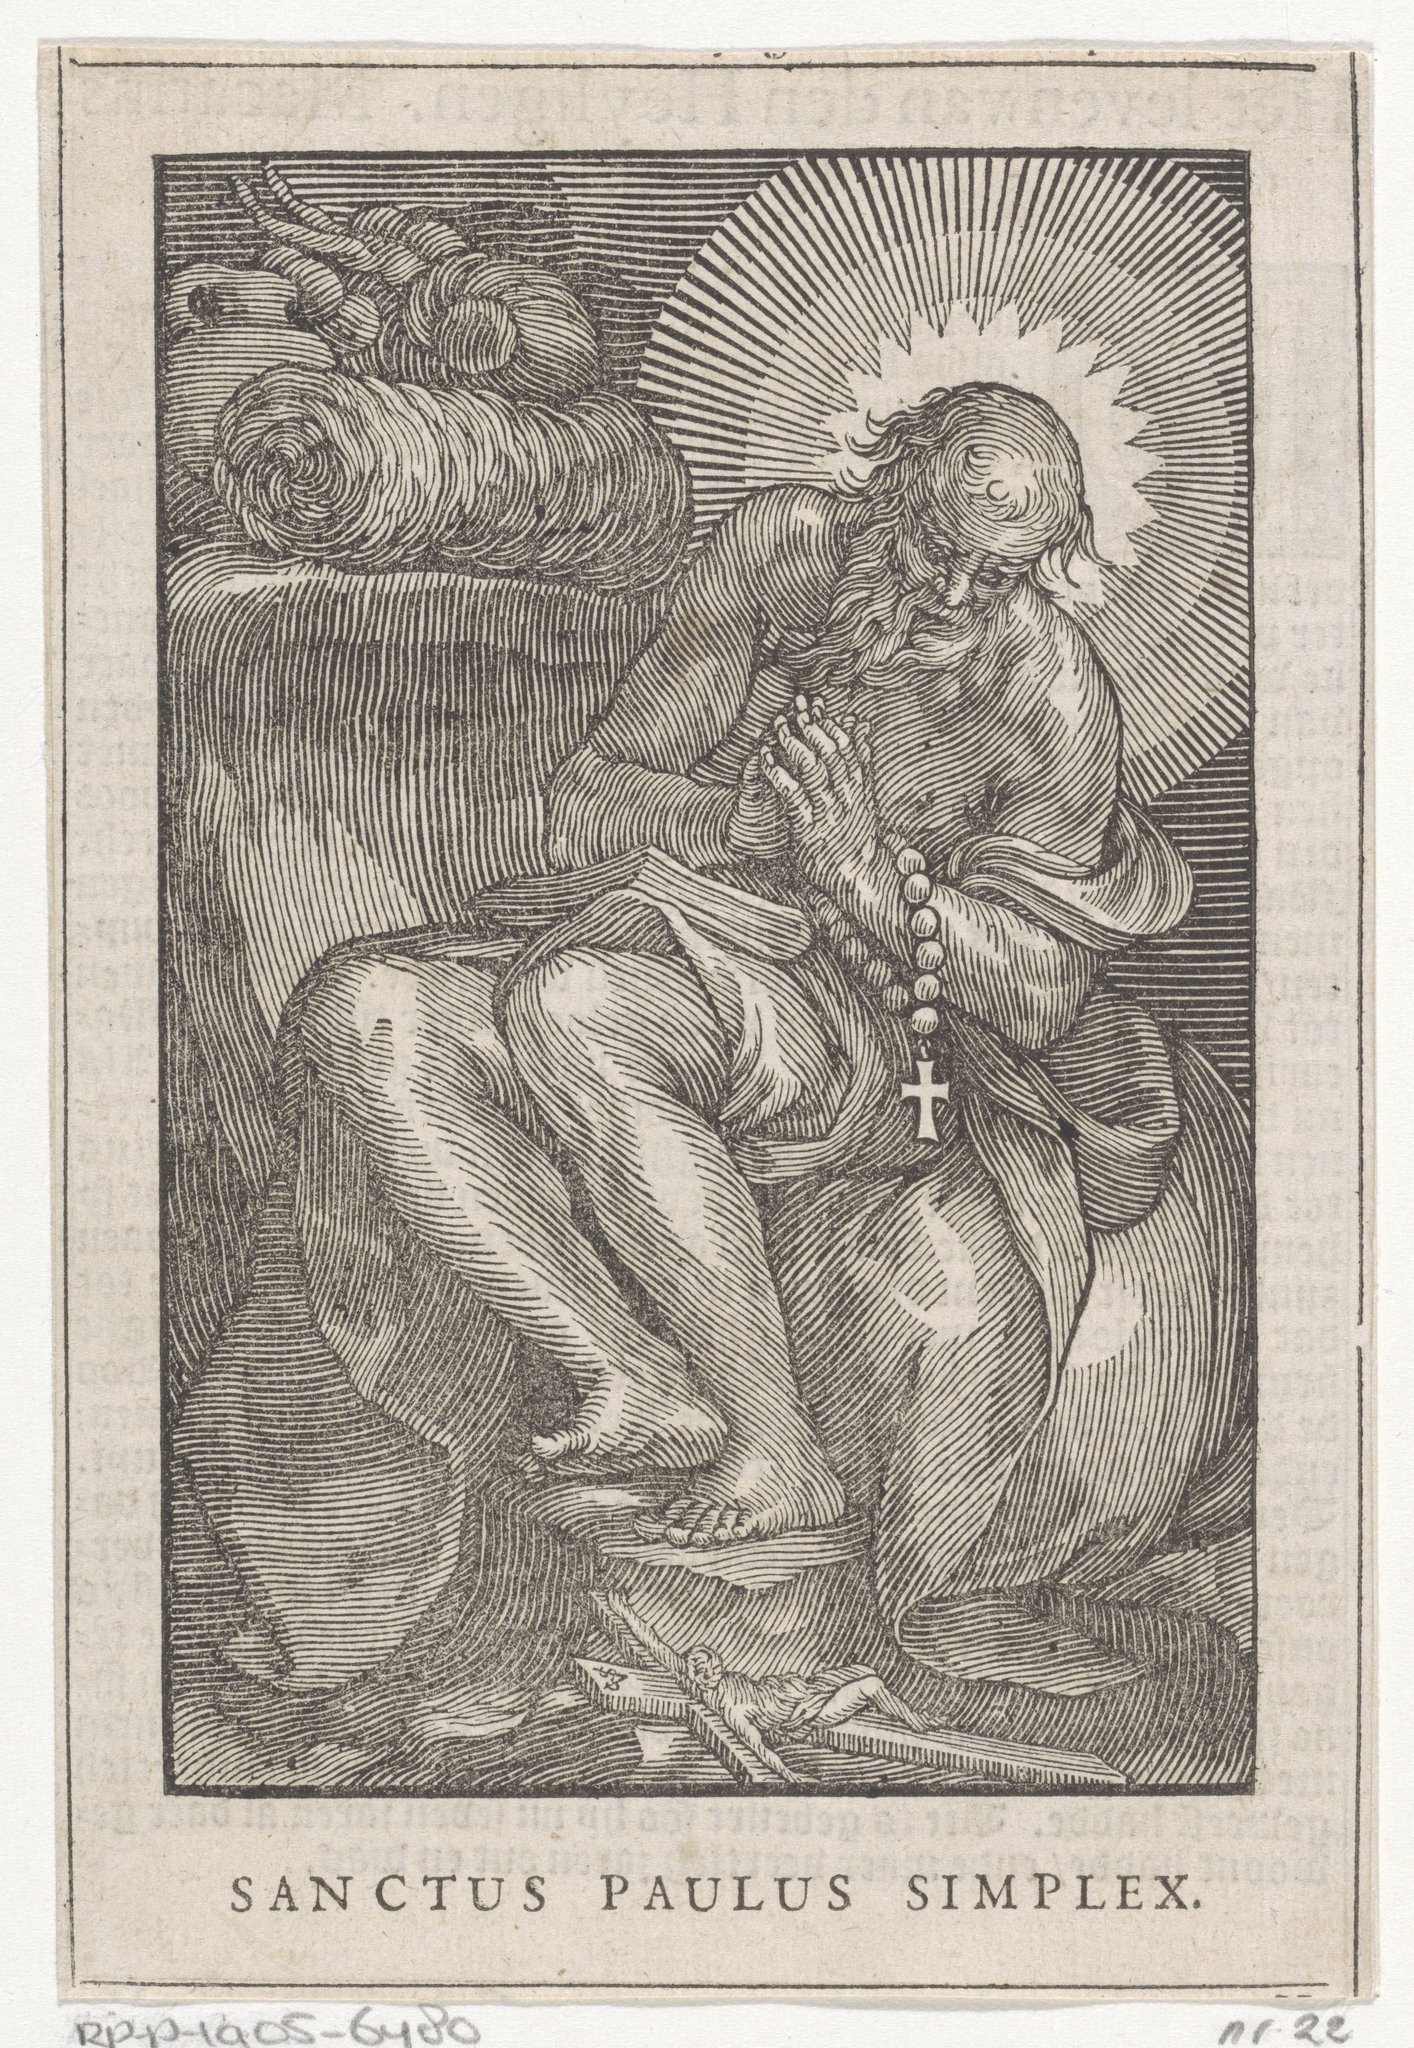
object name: print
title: Sanctus Paulus Simplex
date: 1644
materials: paper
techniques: letterpress printing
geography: amsterdam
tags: saints, anchorite, hermit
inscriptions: collector's mark: Lugt 2228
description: Prent uit: Rosweyde, Heribert. 'tBosch der eremyten ende eremitinnen, van Aegypten ende Palestinen. Amsterdam: Pieter Jacobsz. Paets, 1644.